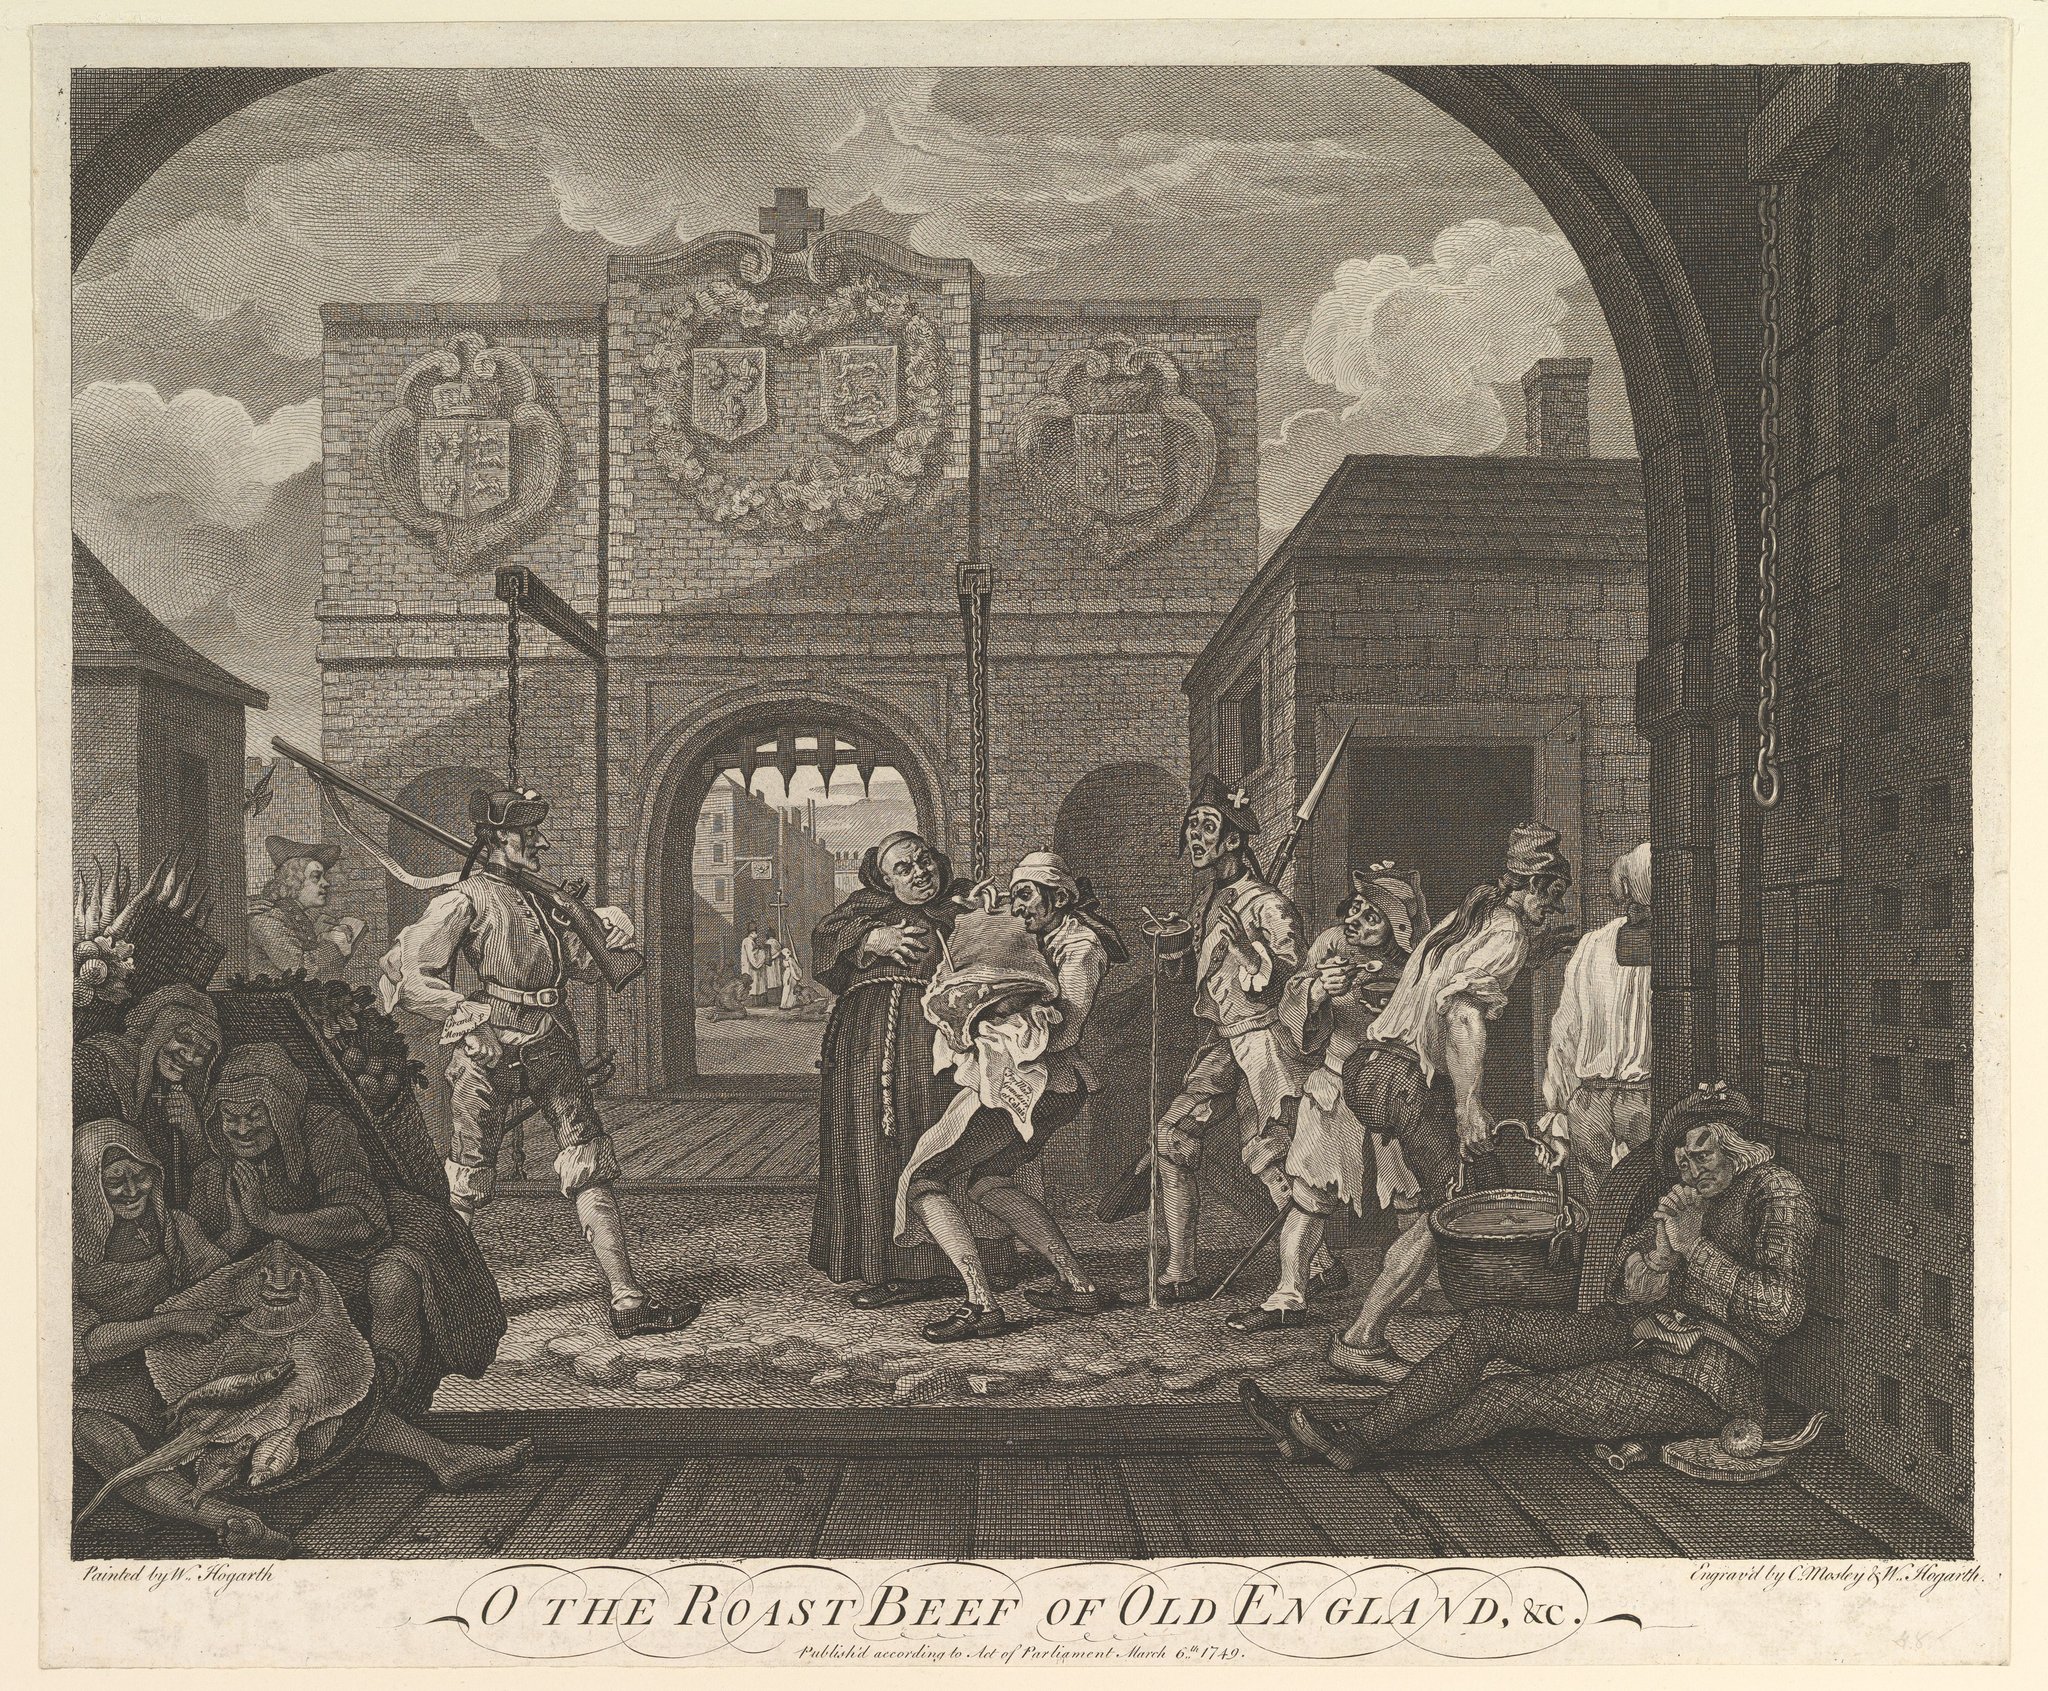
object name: print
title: O the Roast Beef of Old England--The Gate of Calais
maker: william hogarth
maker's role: artist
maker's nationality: british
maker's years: 1697-1764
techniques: engraving, etching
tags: food,architecture,gates,towns,soldiers,vegetables,men,fish,cauldrons,baskets,clergy